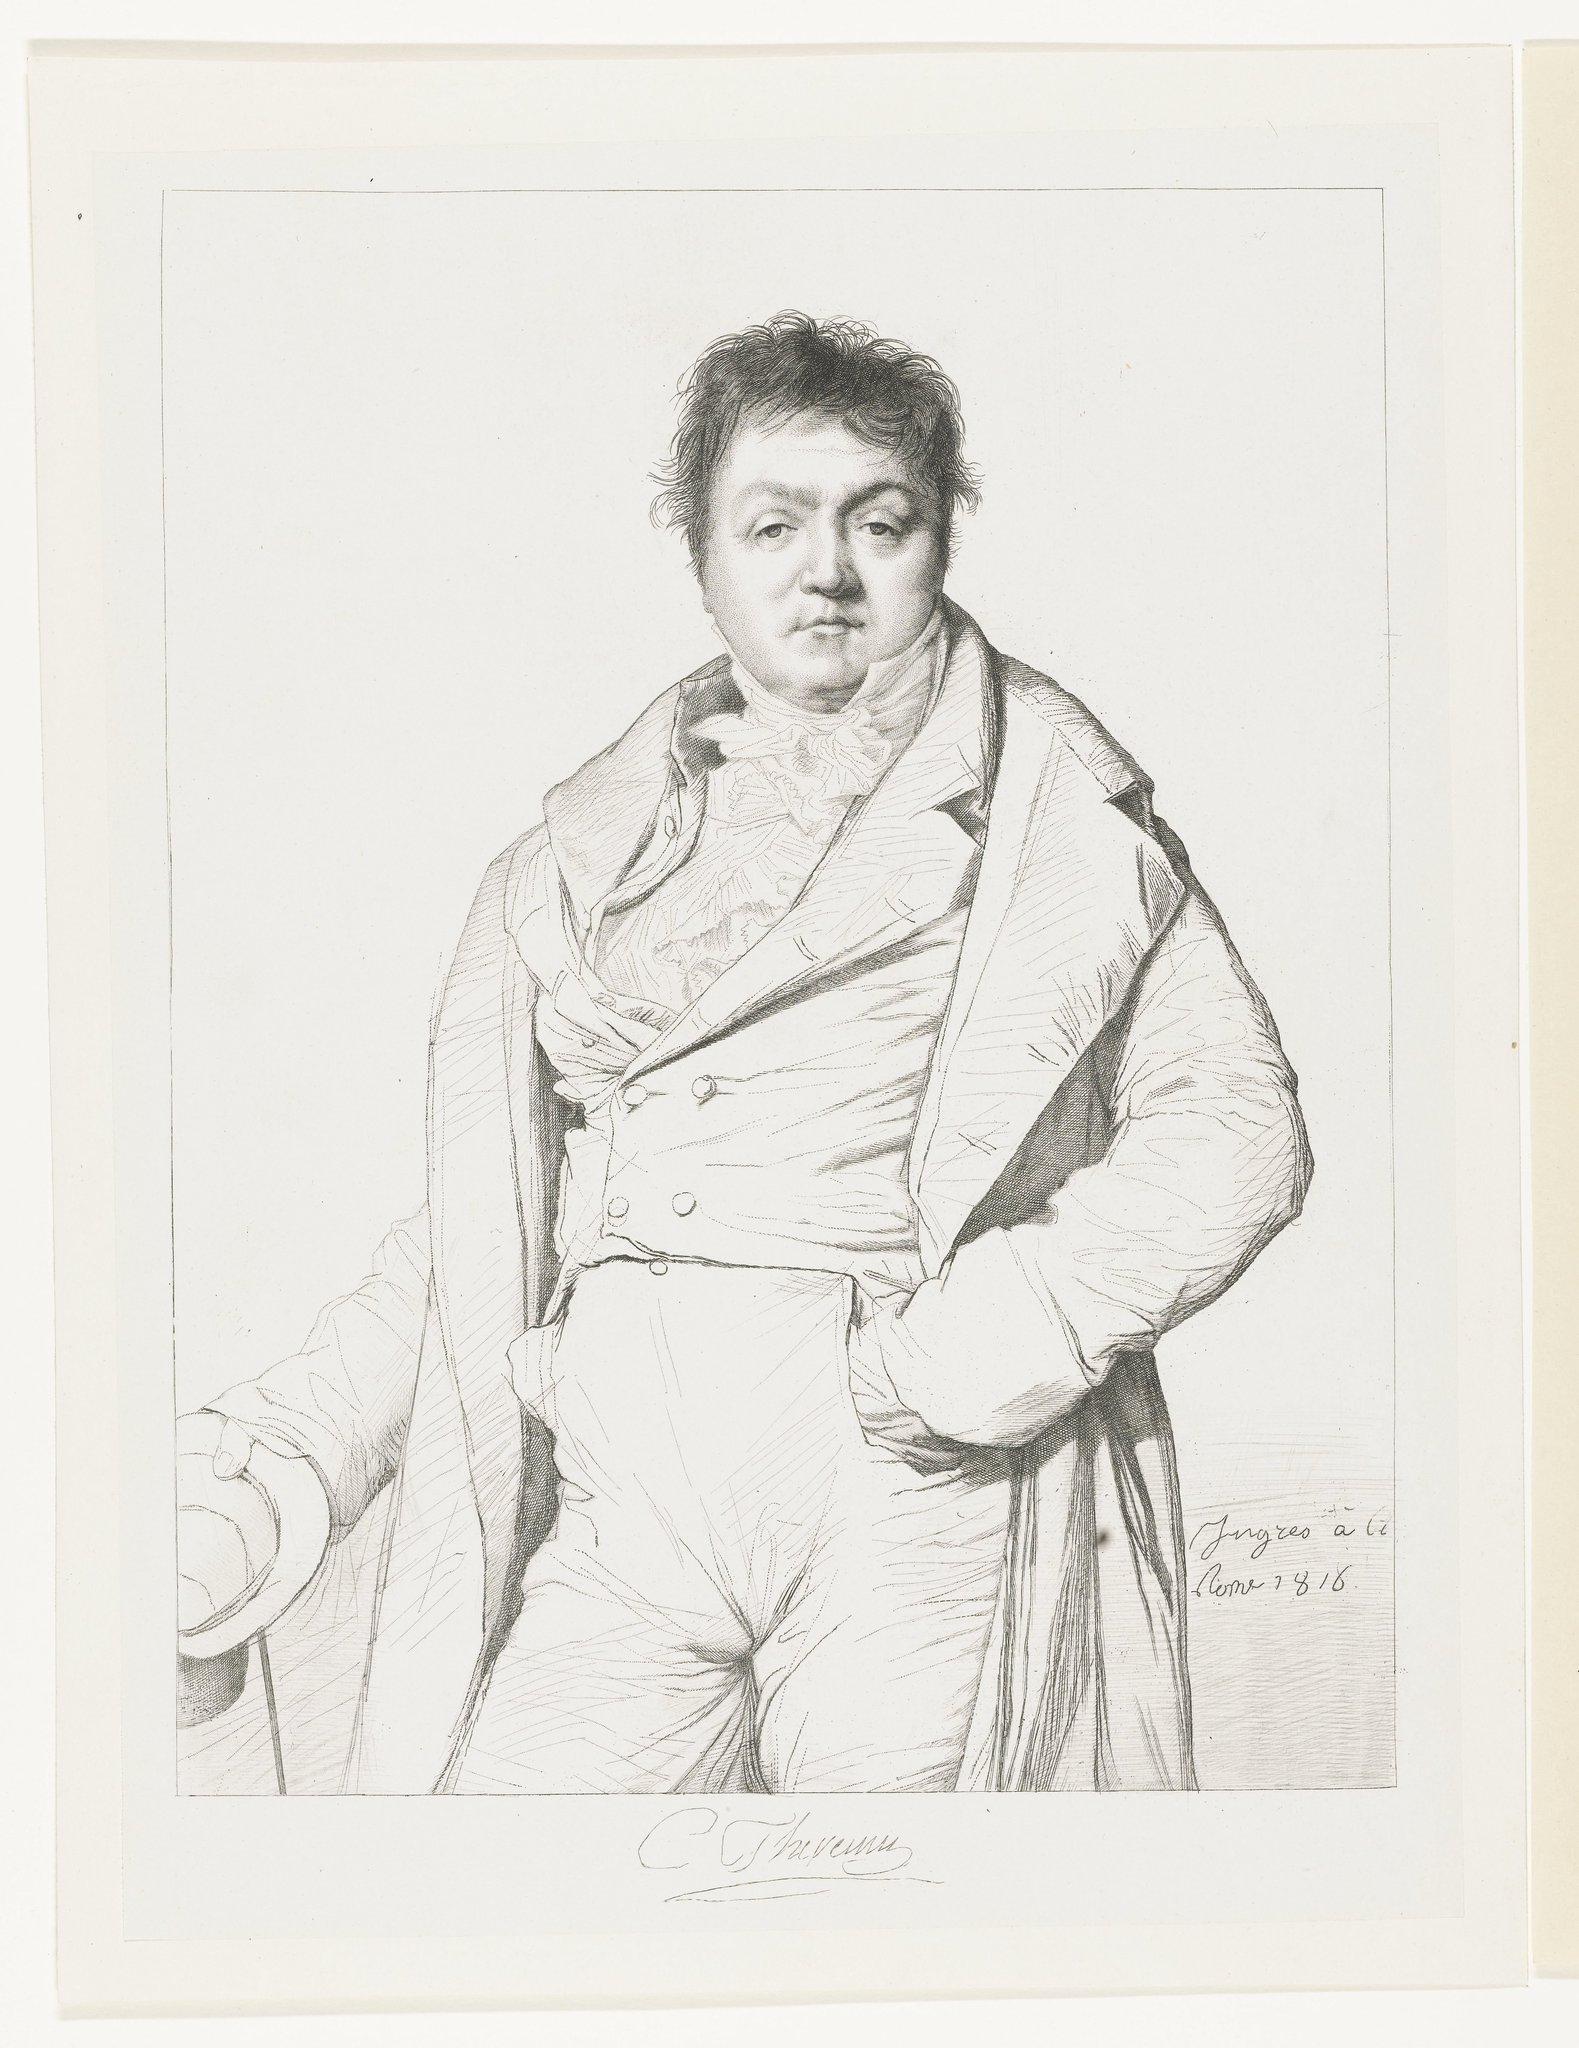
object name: print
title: Portret van Charles Thévenin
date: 1816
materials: paper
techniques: engraving, etching, roulette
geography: amsterdam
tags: paris, charles thévenin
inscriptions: collector's mark: Lugt 2228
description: Prent ook gebruikt als illustratie in: L'album T. douze eaux-fortes d'après des dessins originaux et inédits de Jean Alaux, Léon Cogniet, Coutan, Henriquel Dupont, Ingres, Léopold Robert et Etna Michalon avec texte explicatif et biographique enrichi de lettres inédites. Amsterdam en Den Haag: 1885.